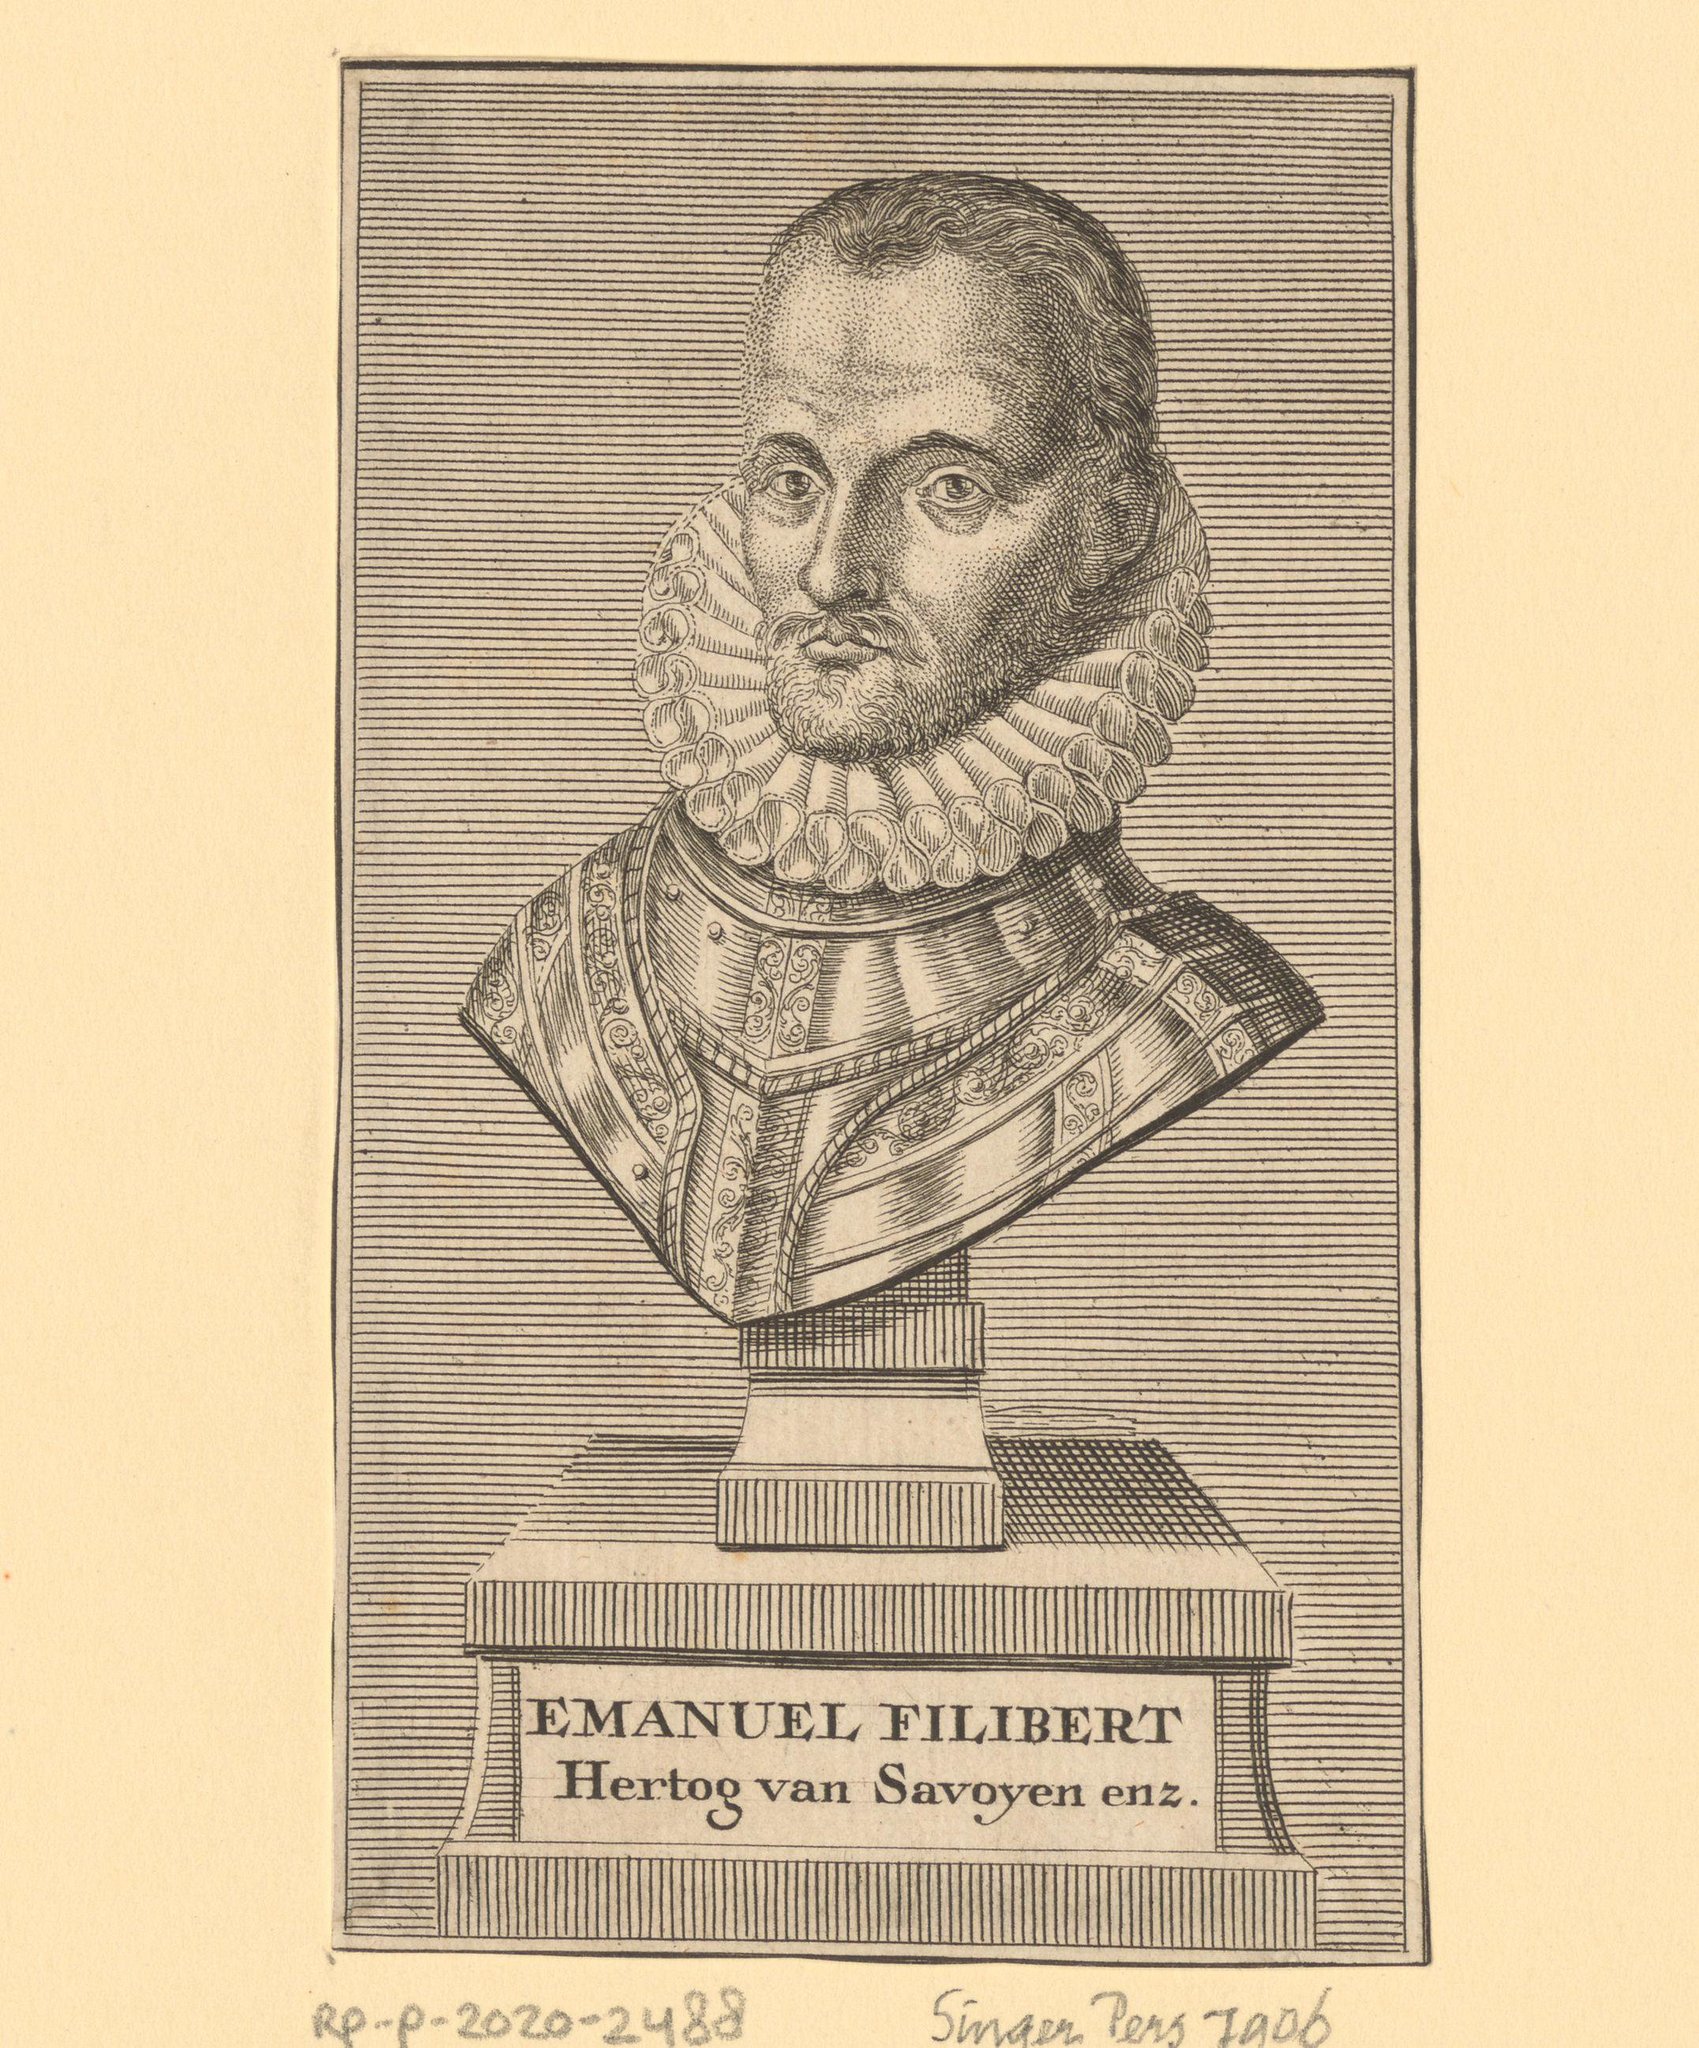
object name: print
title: Portretbuste van Emanuel Filibert van Savoye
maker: Anonymous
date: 1650-1750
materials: paper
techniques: engraving, etching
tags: emanuel filibert (hertog van savoye), armour, historical persons